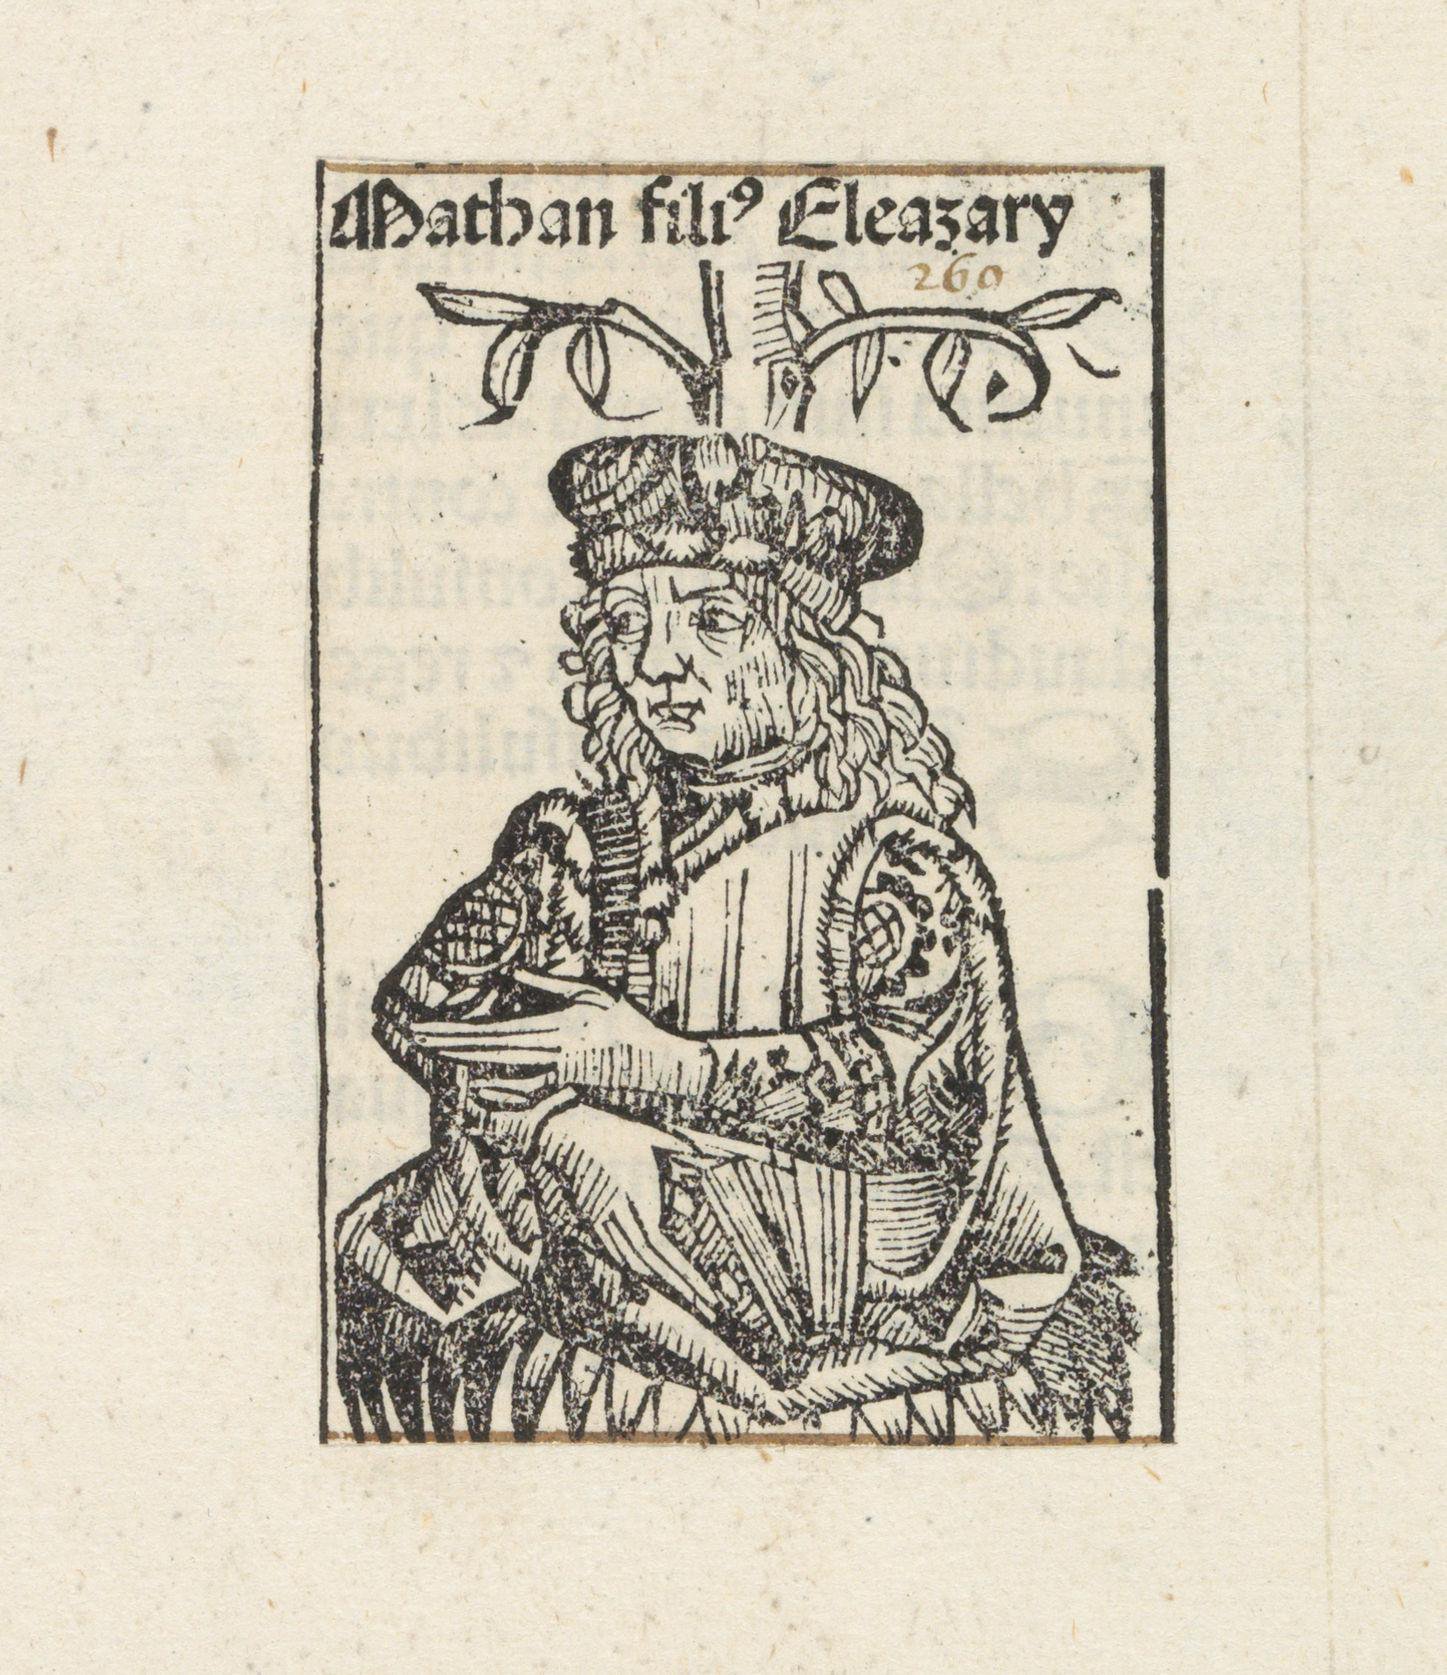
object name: print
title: Liber Chronicarum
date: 1493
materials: paper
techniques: letterpress printing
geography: nuremberg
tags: persons from the old testament (not in biblical context, nor occurring in legendary/historical extensions included in division 71)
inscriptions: inscription: ‘260’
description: Een bloemkelk met een edelman, naar links gekeerd. De tekst identificeert hem als Mattan, zoon van Eleazar (Mat. 1:15). De voorstelling is onderdeel van de stamboom van Christus in de Liber Chronicarum. De prent maakt deel uit van een album.